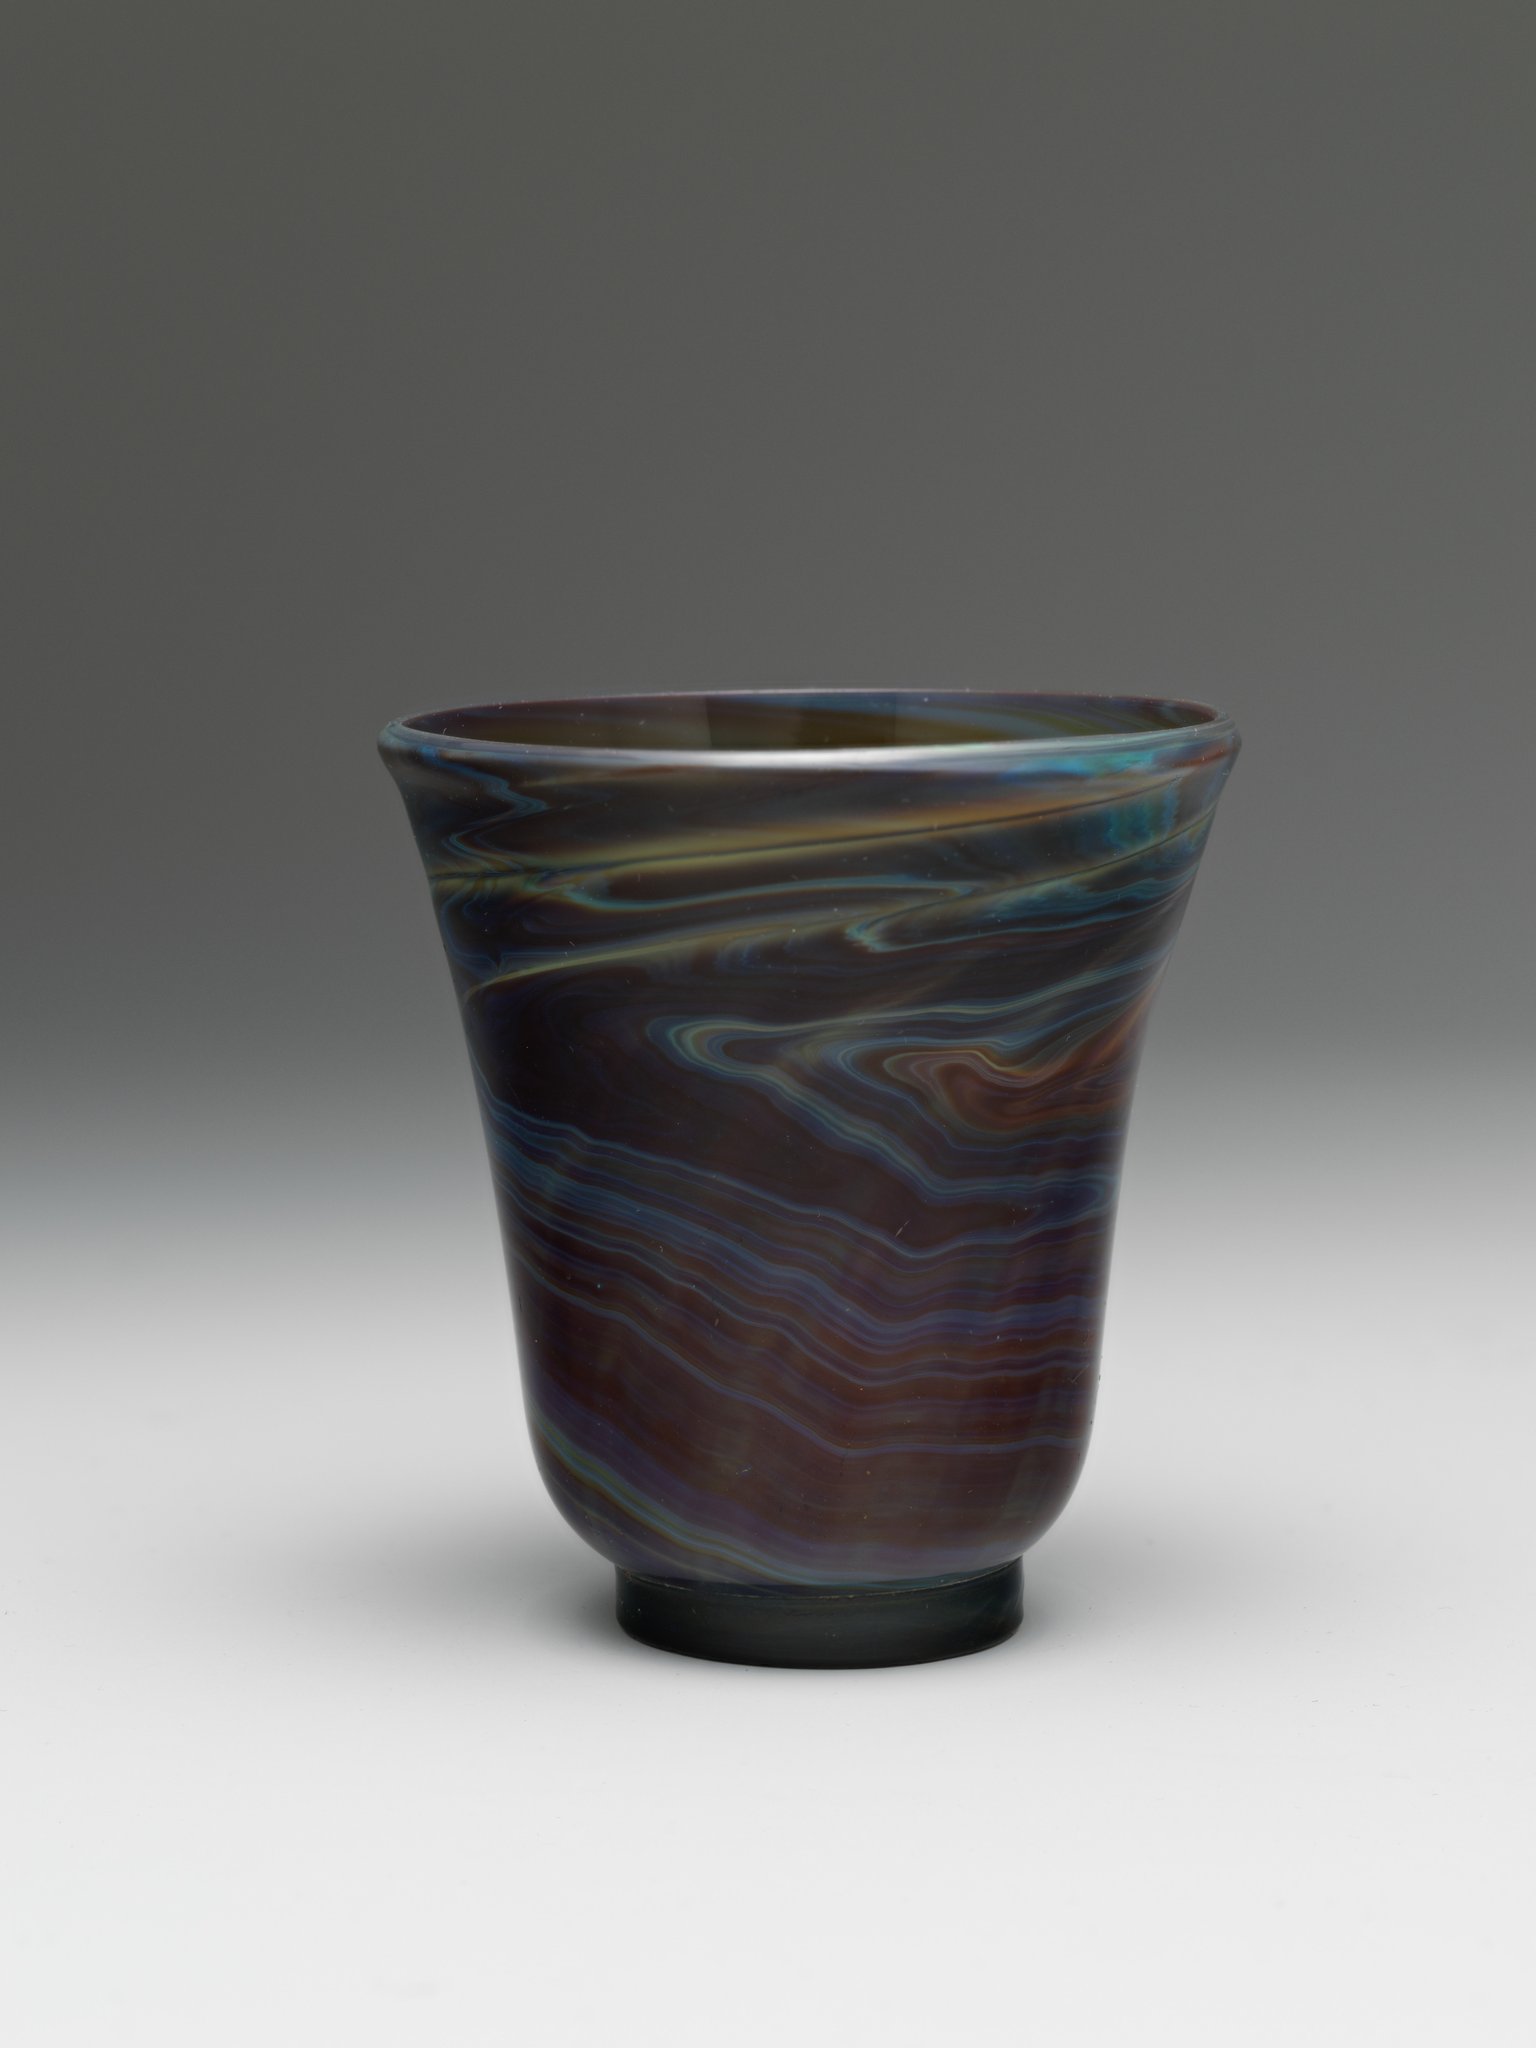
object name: cup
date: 1701-1900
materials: glass